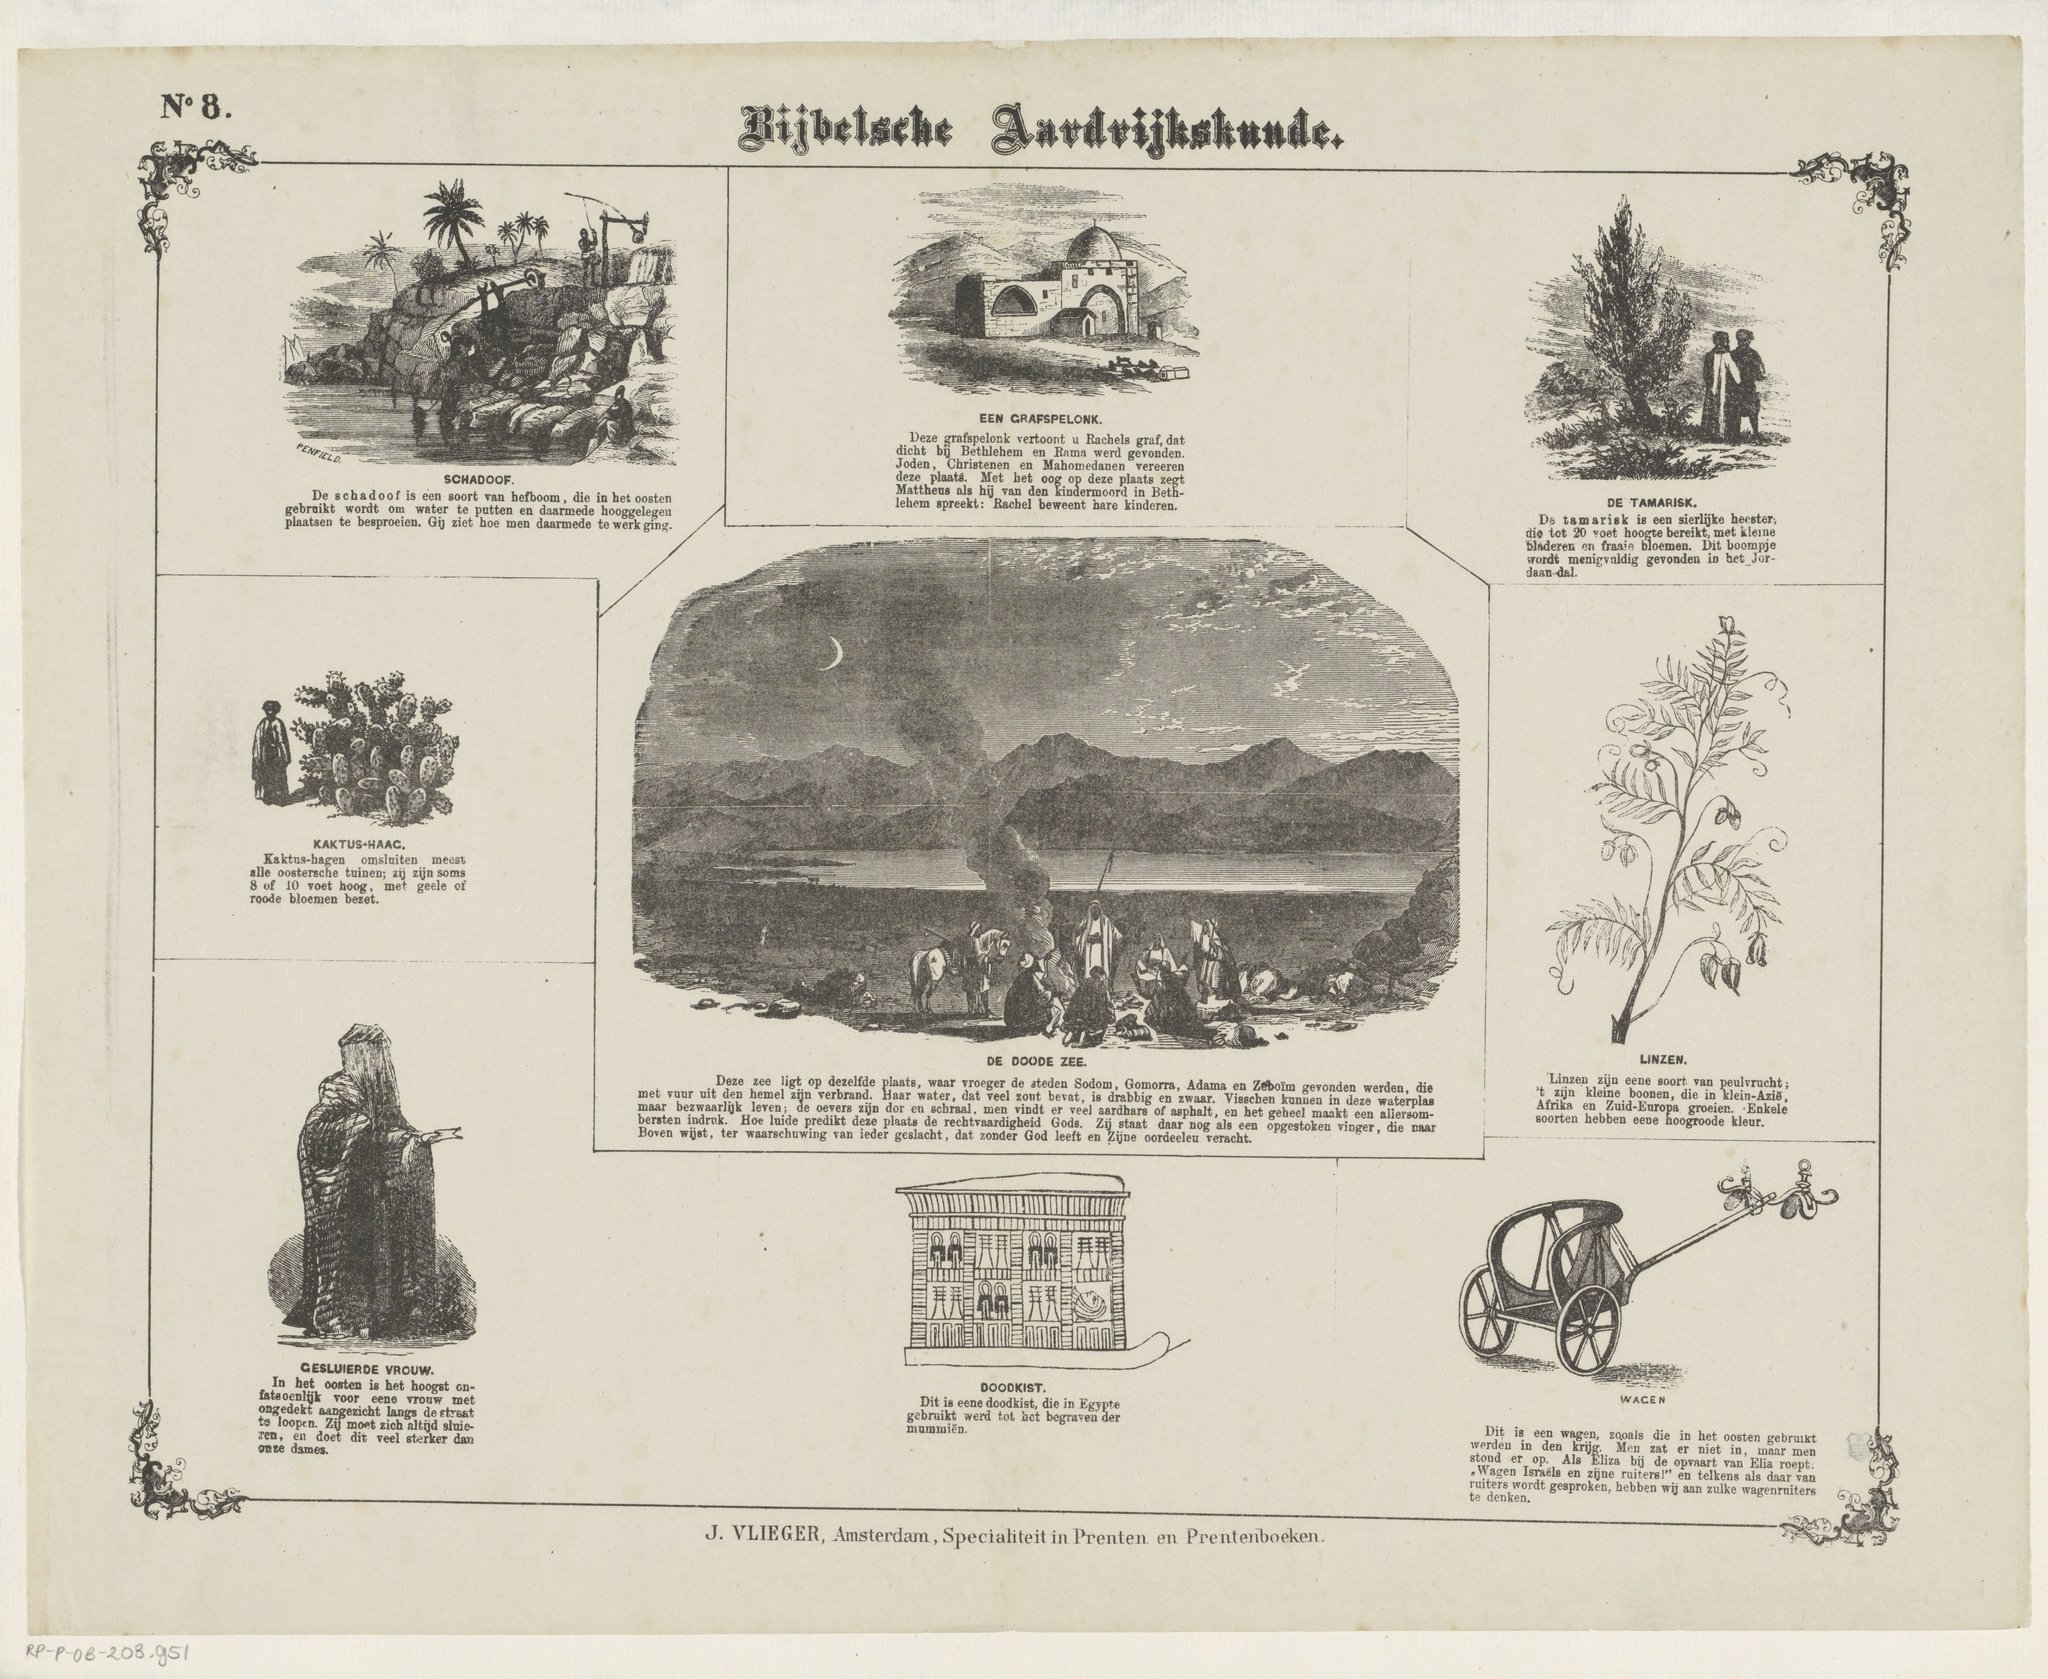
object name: print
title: Bijbelsche aardrijkskunde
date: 1871-1908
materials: paper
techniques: letterpress printing, engraving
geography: amsterdam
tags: plants; vegetation, coffin, plants and herbs: cactus, veil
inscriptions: collector's mark: Lugt 2760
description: Blad met 9 voorstellingen van voorwerpen, planten, een gesluierde vrouw en de Dode Zee. Onder elke afbeelding een onderschrift. Genummerd linksboven: No. 8.